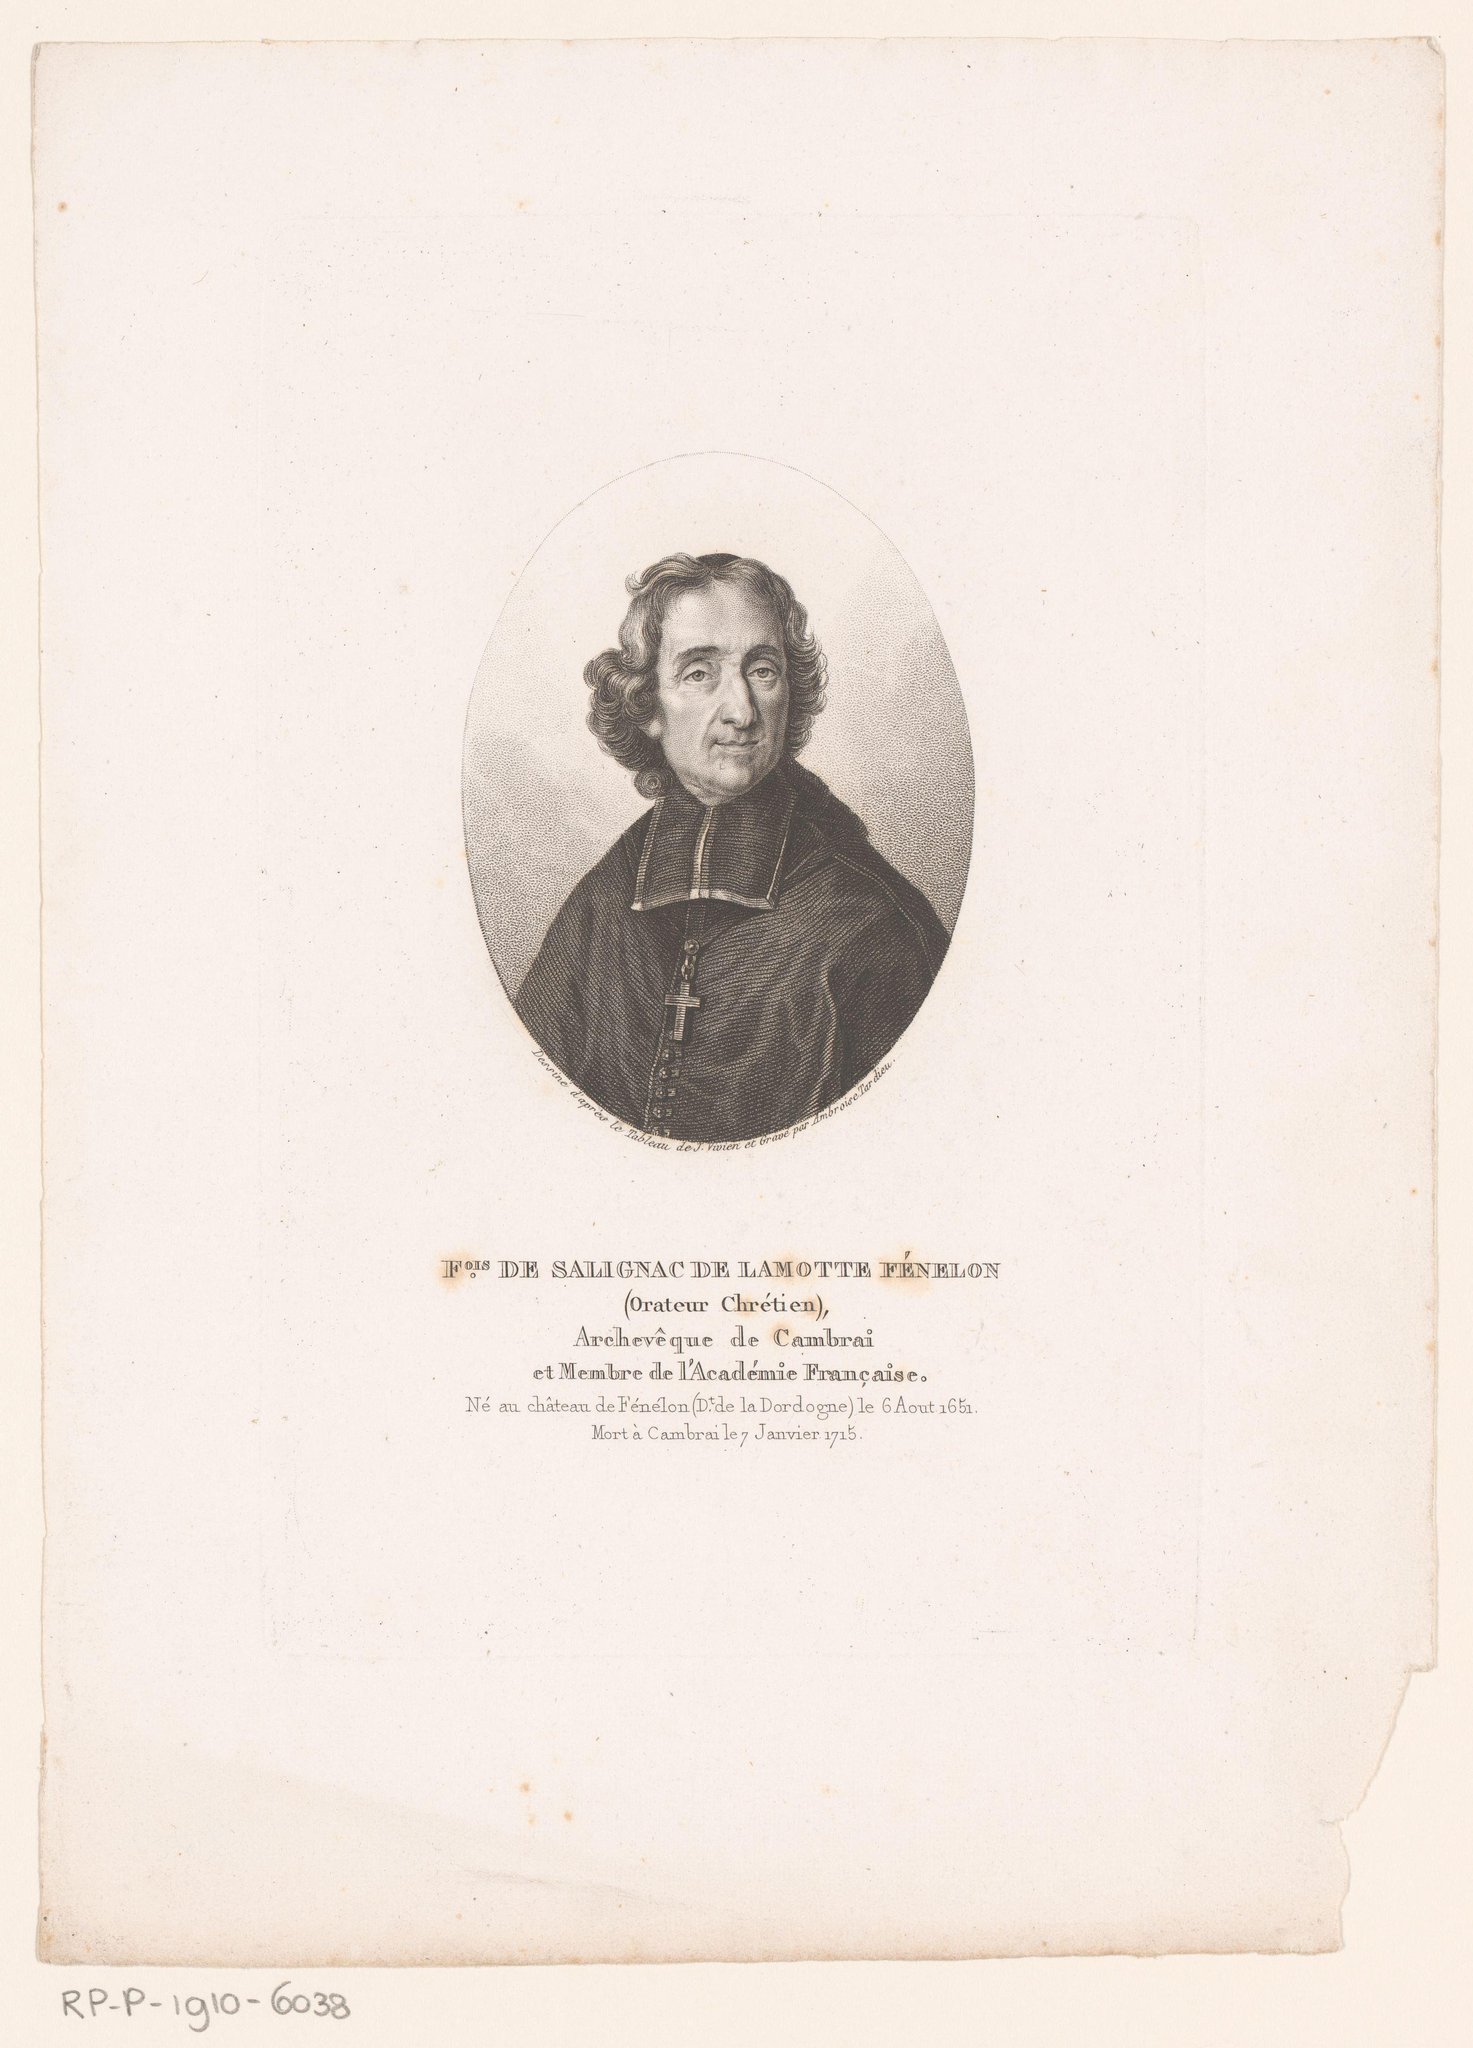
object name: print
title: Portret van François Fénelon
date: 1820-1828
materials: paper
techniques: engraving, roulette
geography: paris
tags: françois fénelon, archbishop, bishop, etc. (roman catholic), historical persons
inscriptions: collector's mark: Lugt 2228